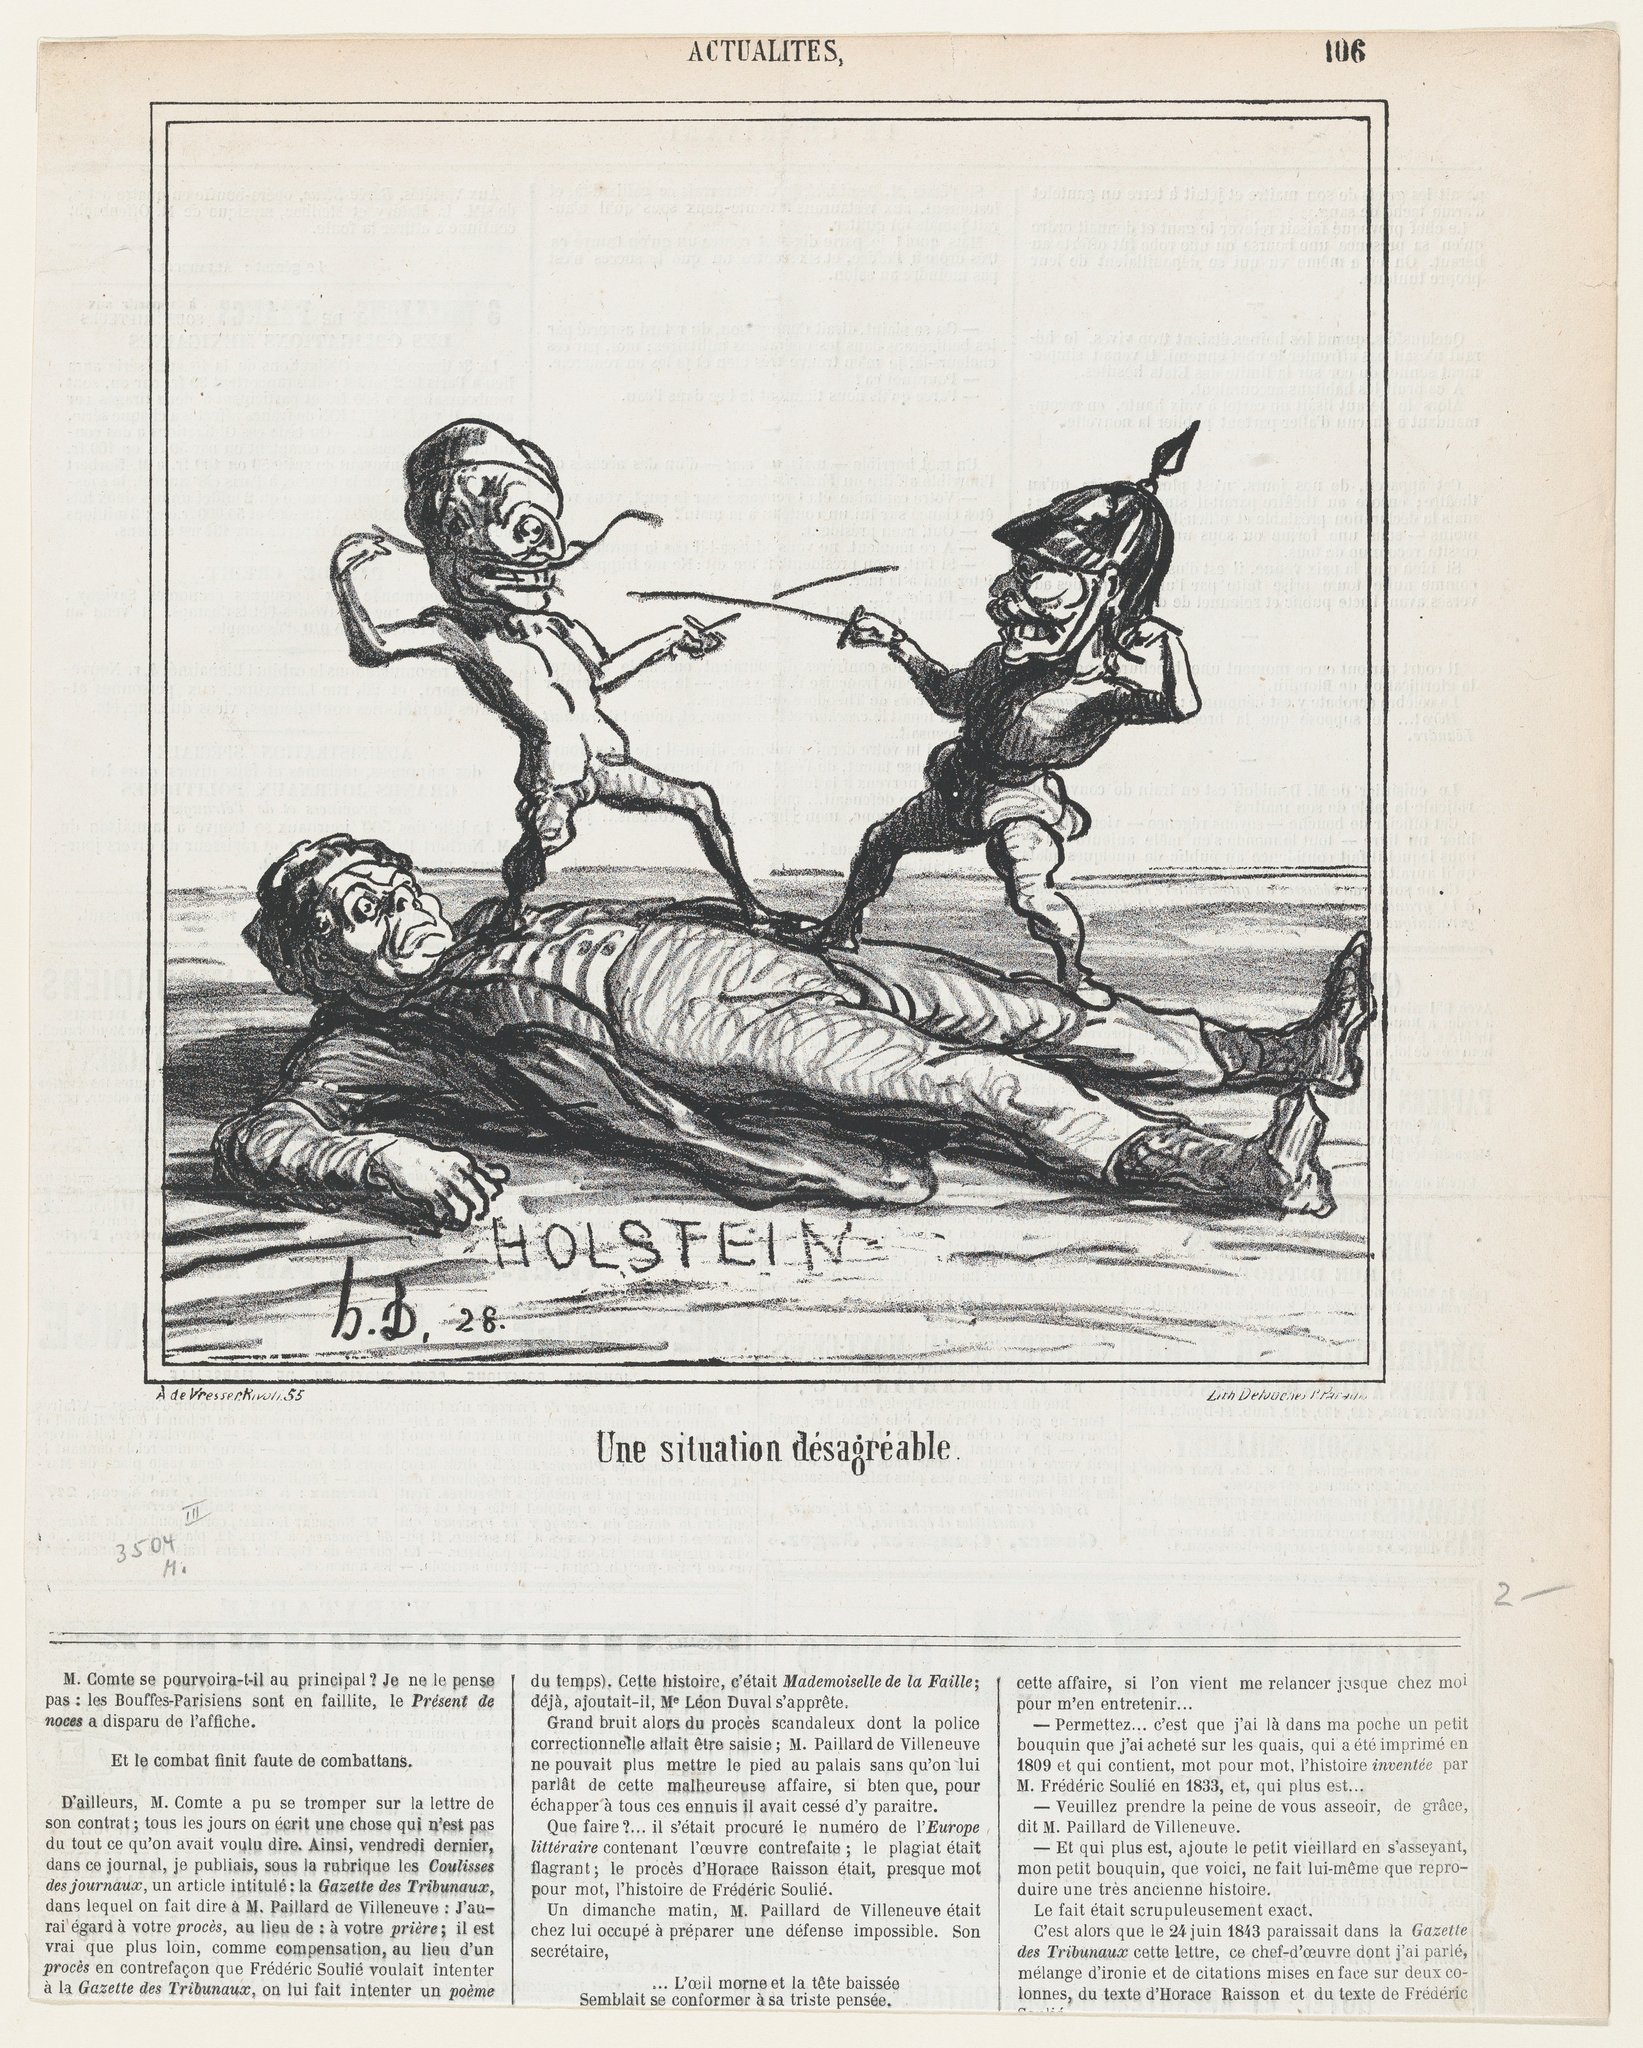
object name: print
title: An uncomfortable situation, from 'News of the day,' published in Le Charivari, June 5, 1866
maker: honoré daumier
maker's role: artist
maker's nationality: french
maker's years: 1808-1879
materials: paper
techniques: lithograph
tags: satire,men